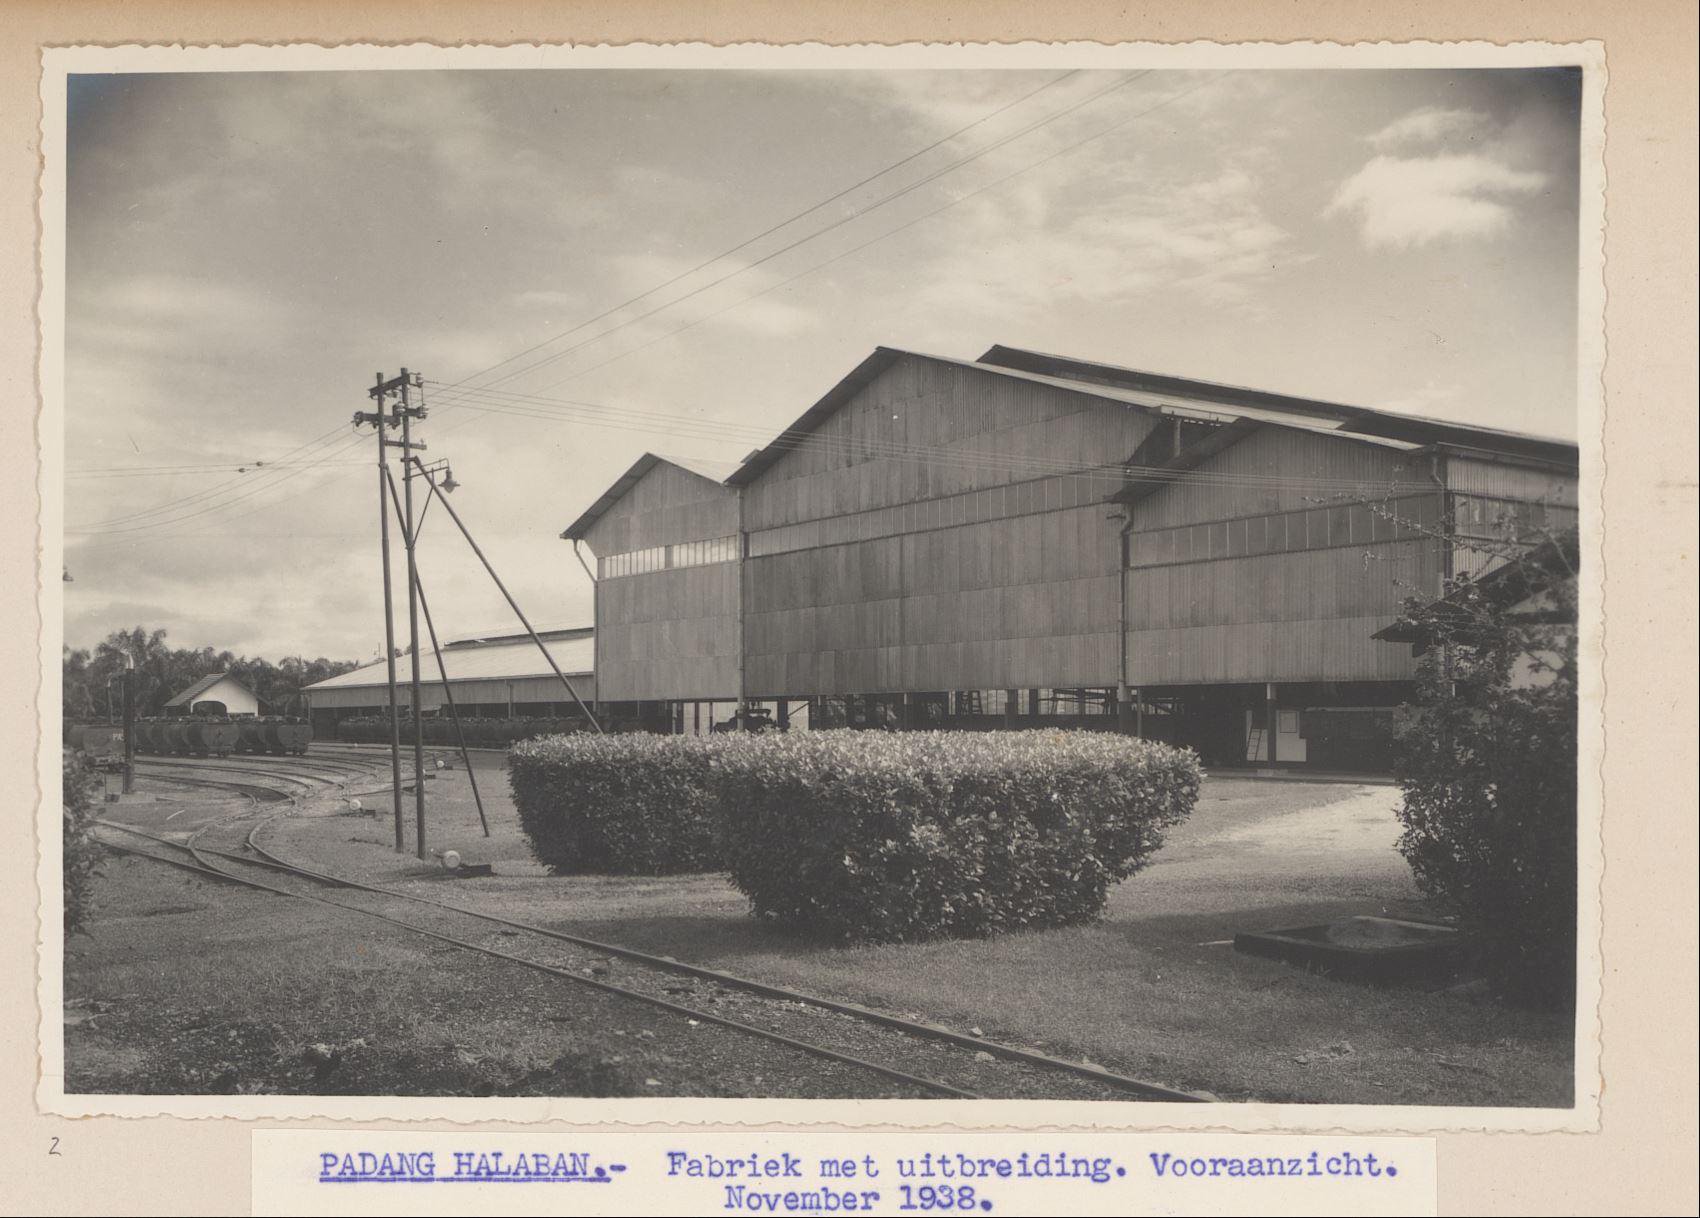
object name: photograph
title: Padang Halaban - Fabriek met uitbreiding. Vooraanzicht. November 1938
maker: Anonymous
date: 1911-1938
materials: photographic support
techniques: gelatin silver print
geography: sumatra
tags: plantation, factory-building, (non-fruit) products of plants or trees: palm oil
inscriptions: inscription: ‘Padang Halaban - Fabriek met uitbreiding. Vooraanzicht. November 1938’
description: Gezicht op de palmoliefabriek op de plantage Padang Halaban, november 1938. Op de voorgrond een treinspoor. Onderdeel van het fotoalbum over de plantages Pernantian en Brussel van de Sumatra Caoutchouc Maatschappij op de Oostkust van Sumatra in de jaren 1935-1939.